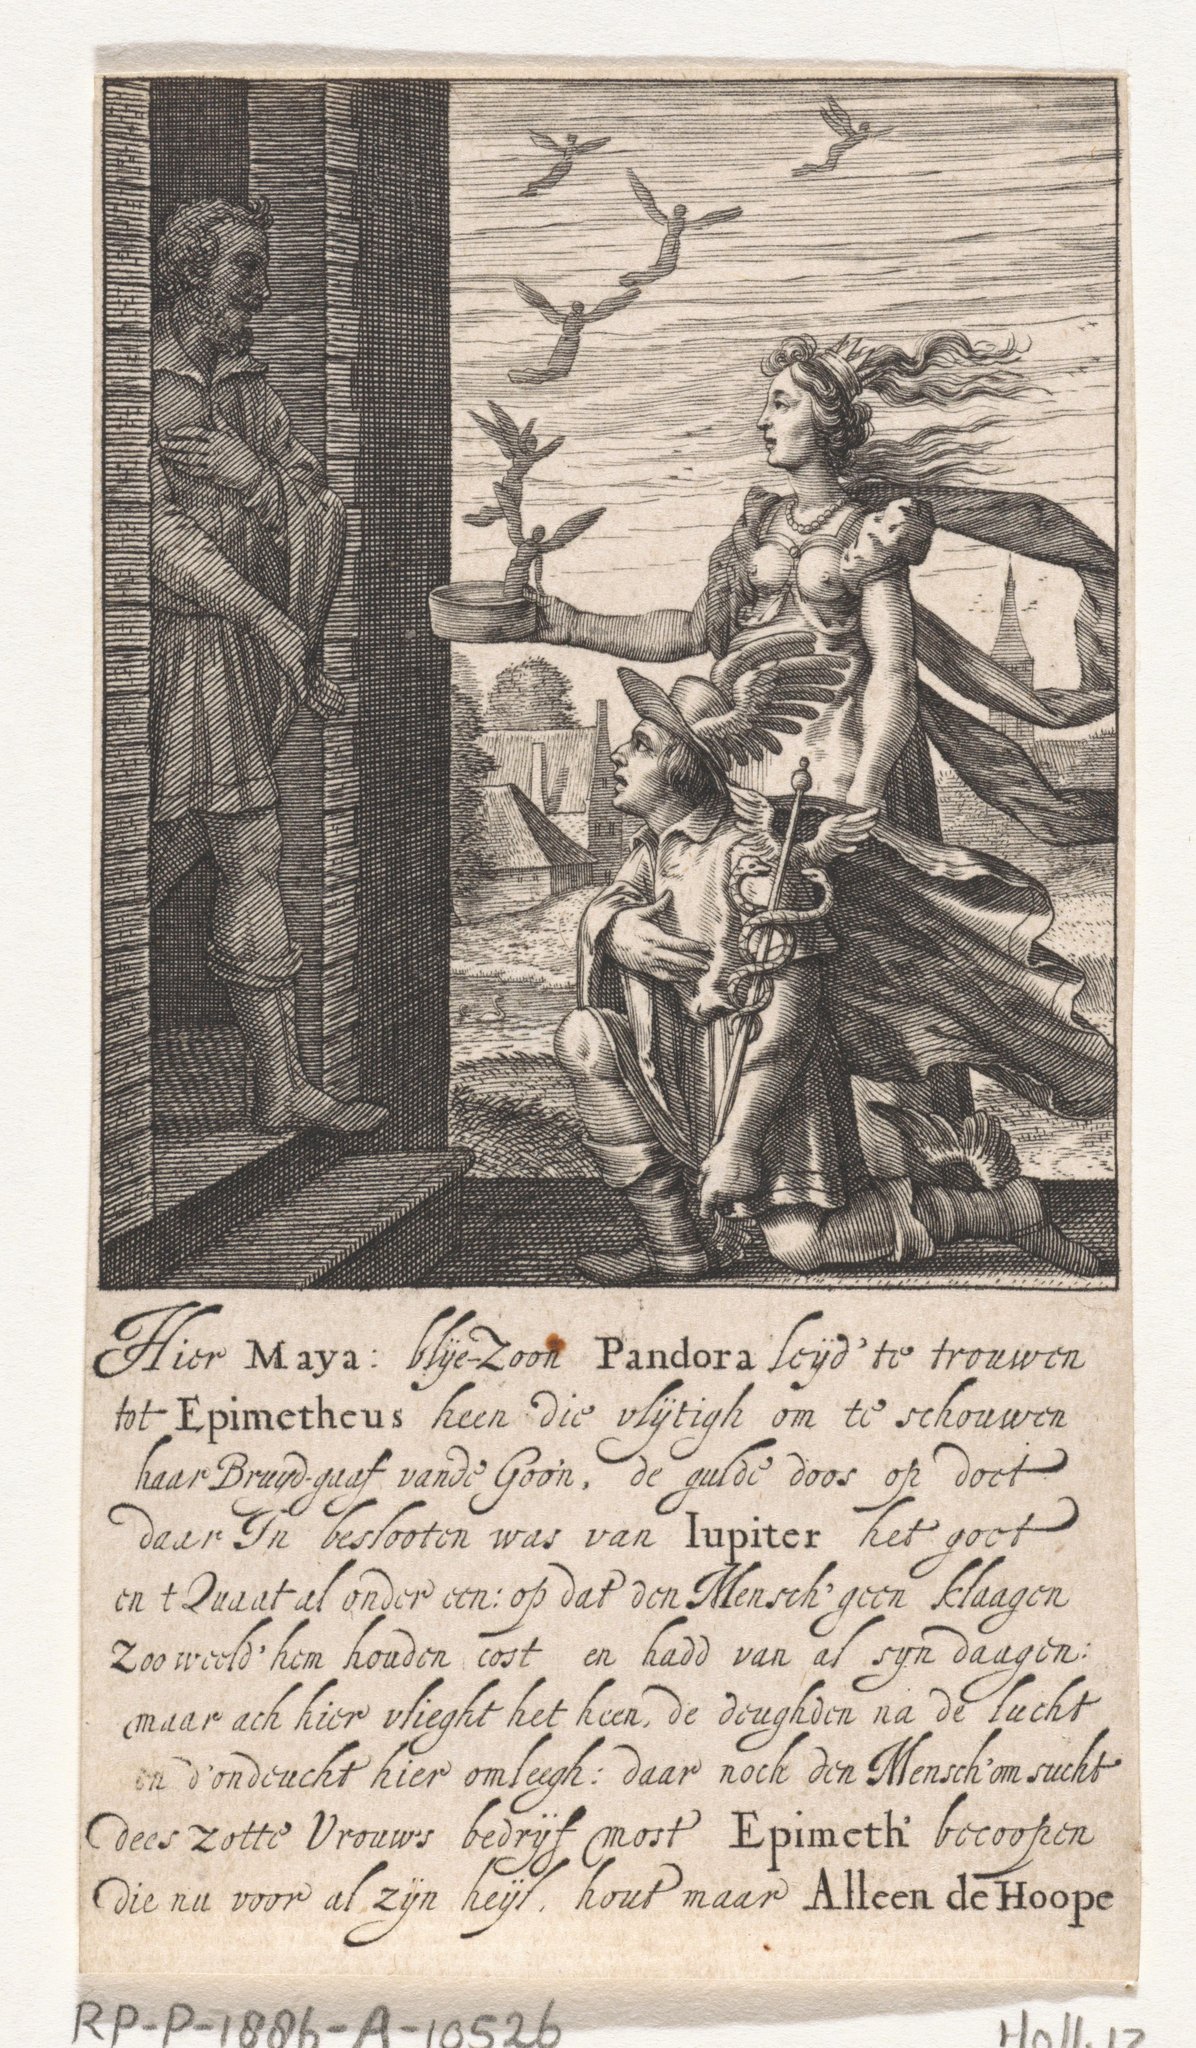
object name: print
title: Pandora en Epimetheus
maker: pieter serwouters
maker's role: draughtsman, print maker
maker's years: 1586-1657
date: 1601-1657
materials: paper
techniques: engraving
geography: amsterdam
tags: (story of) mercury (hermes), (story of) pandora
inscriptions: collector's mark: Lugt 2228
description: Pandora toont de geopende doos aan haar man Epimetheus. Uit de doos vliegen de door Jupiter ingesloten deugden en ondeugden. Naast Pandora knielt Mercurius. Hij houdt zijn staf in de linkerhand. Onder de afbeelding een tienregelige toelichting op de voorstelling.